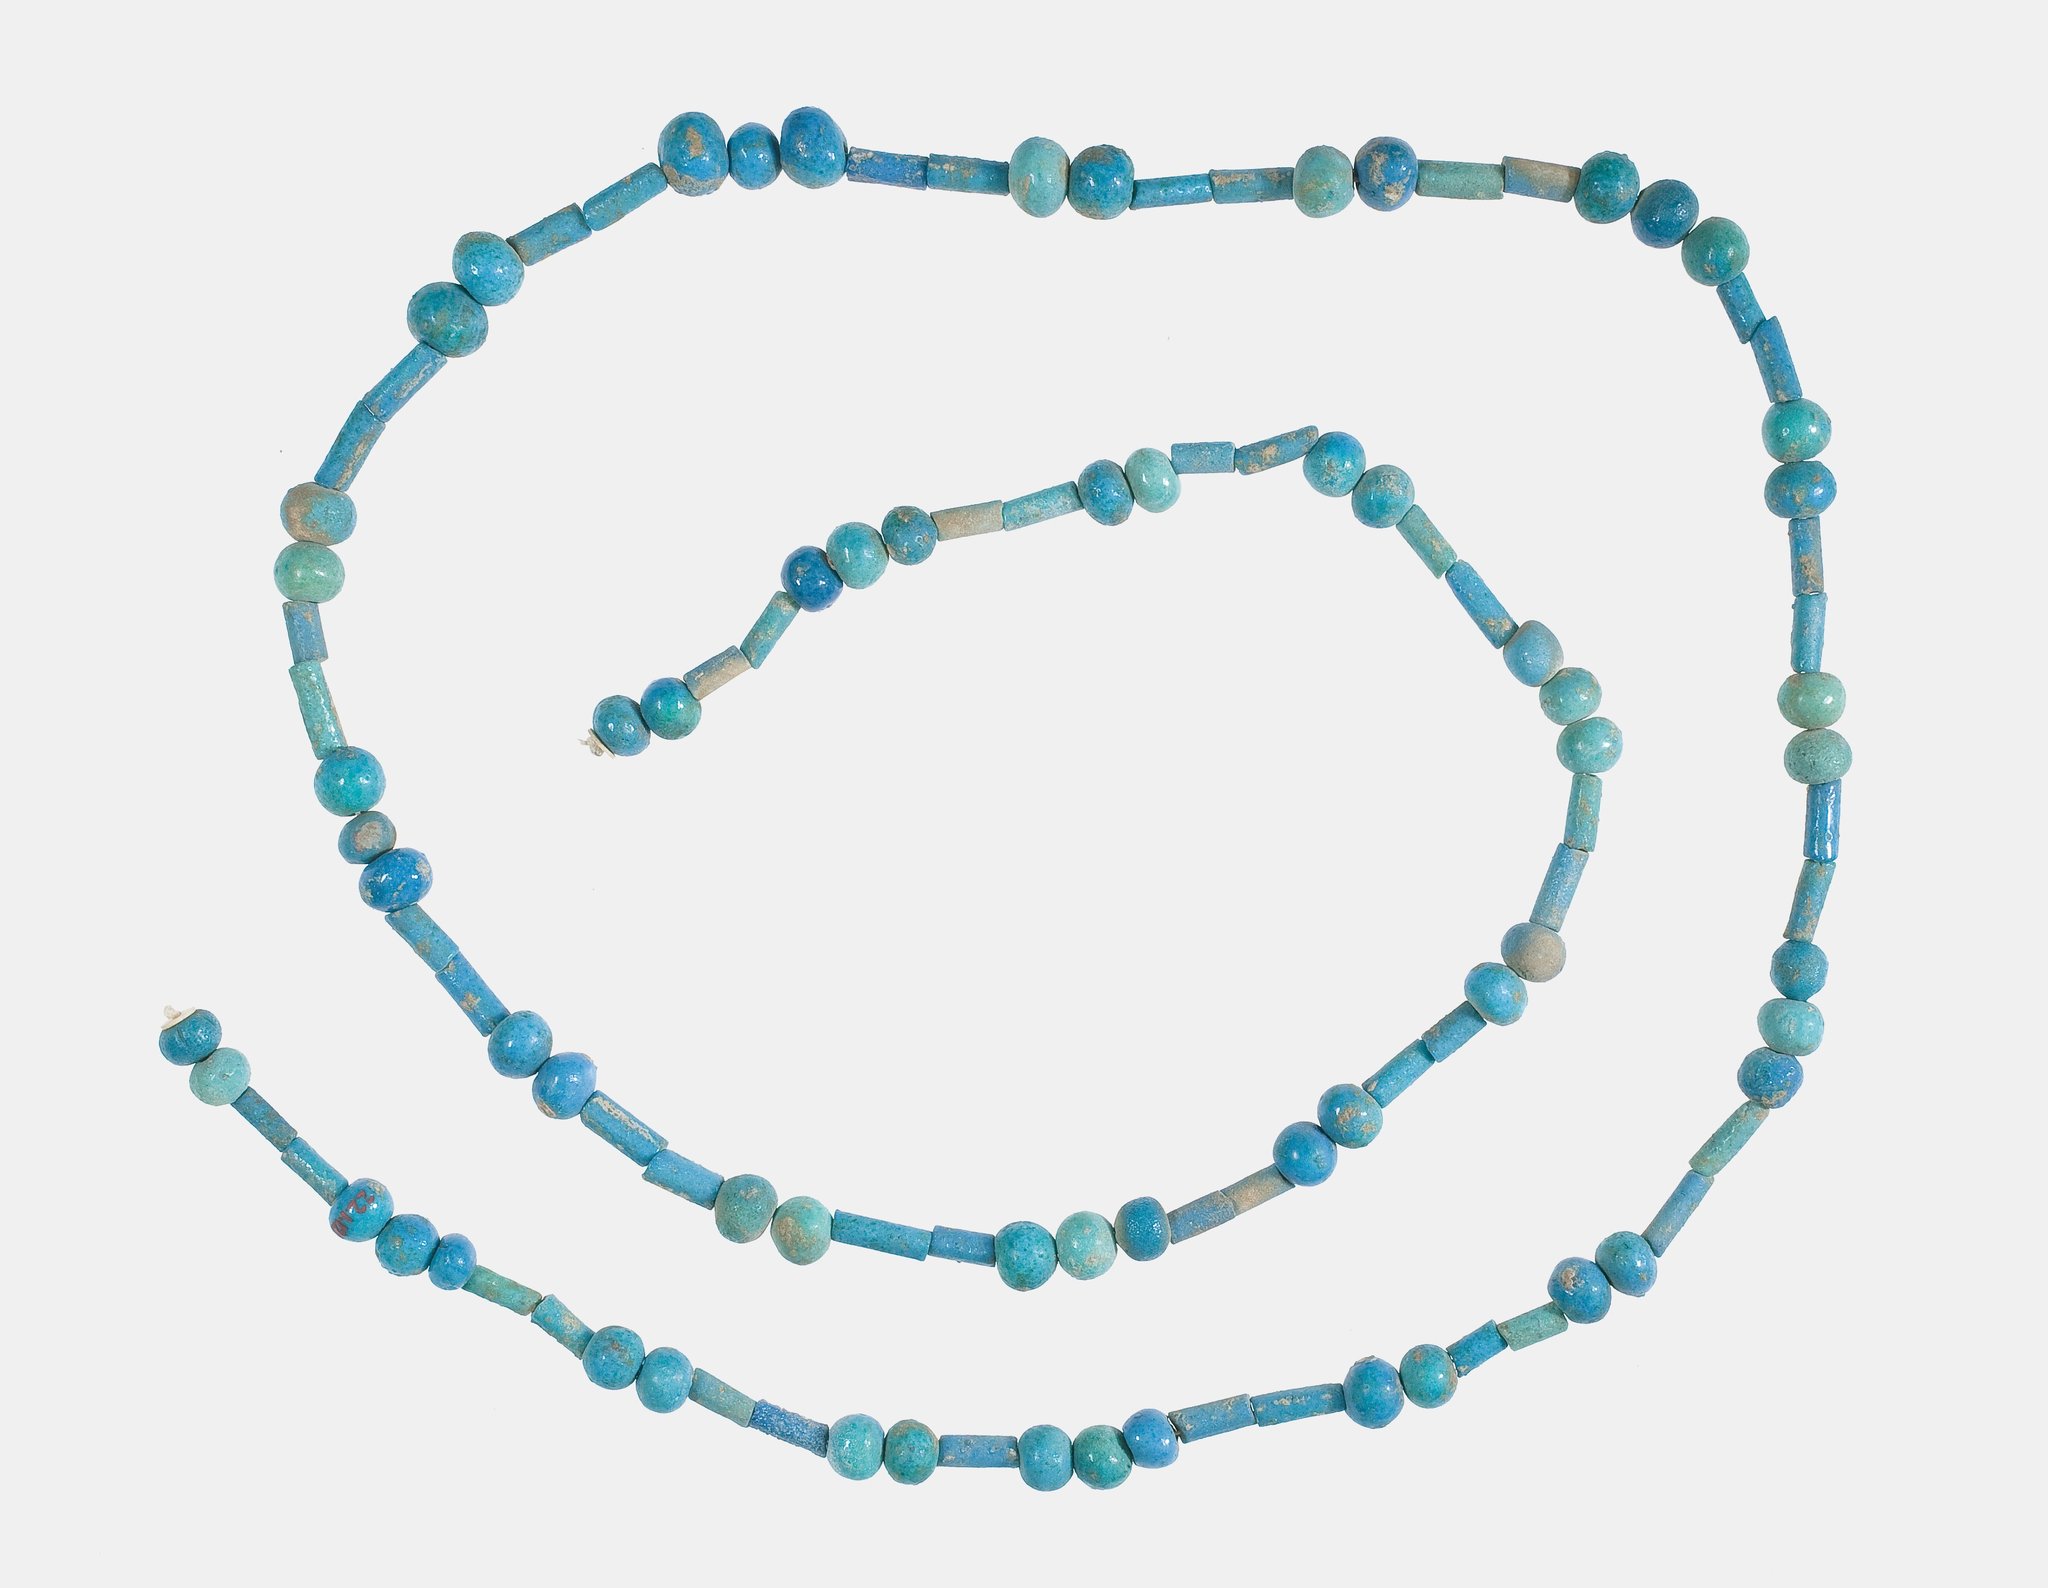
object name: necklace, bead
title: String of blue faience ball and cylinder beads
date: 1802-1450 BCE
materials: faience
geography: egypt